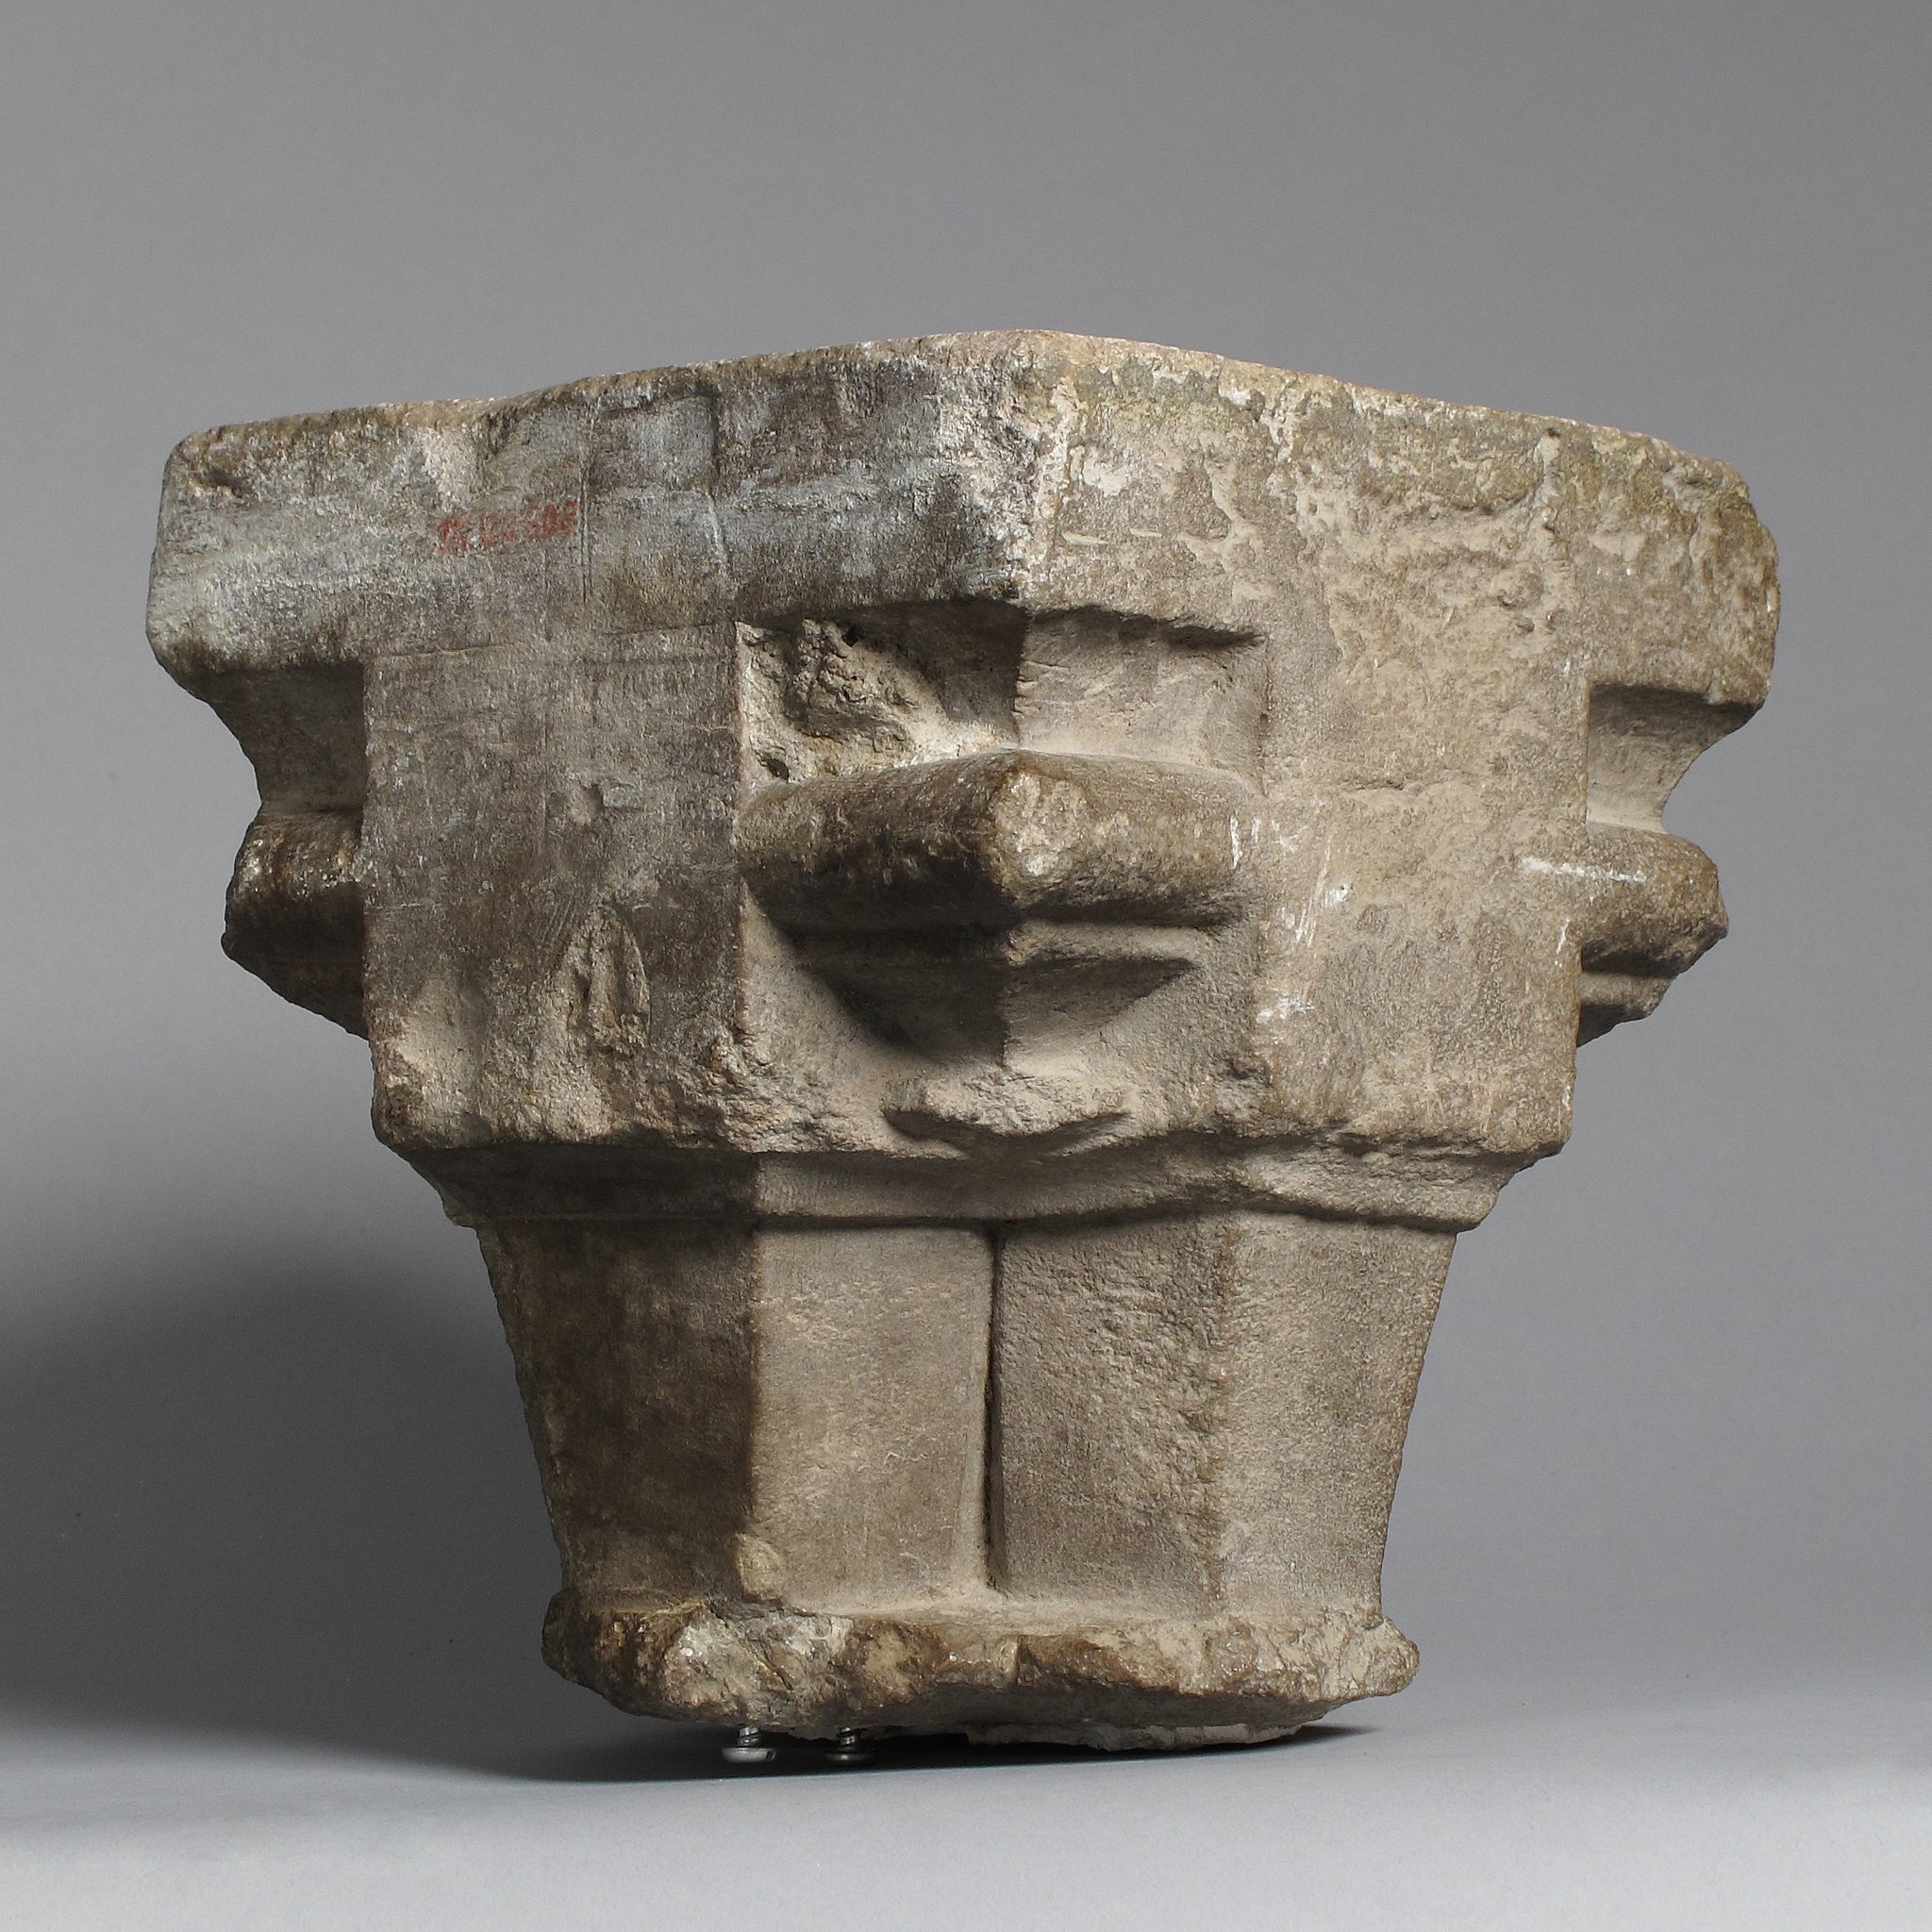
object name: capital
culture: french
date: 1301-1400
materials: stone